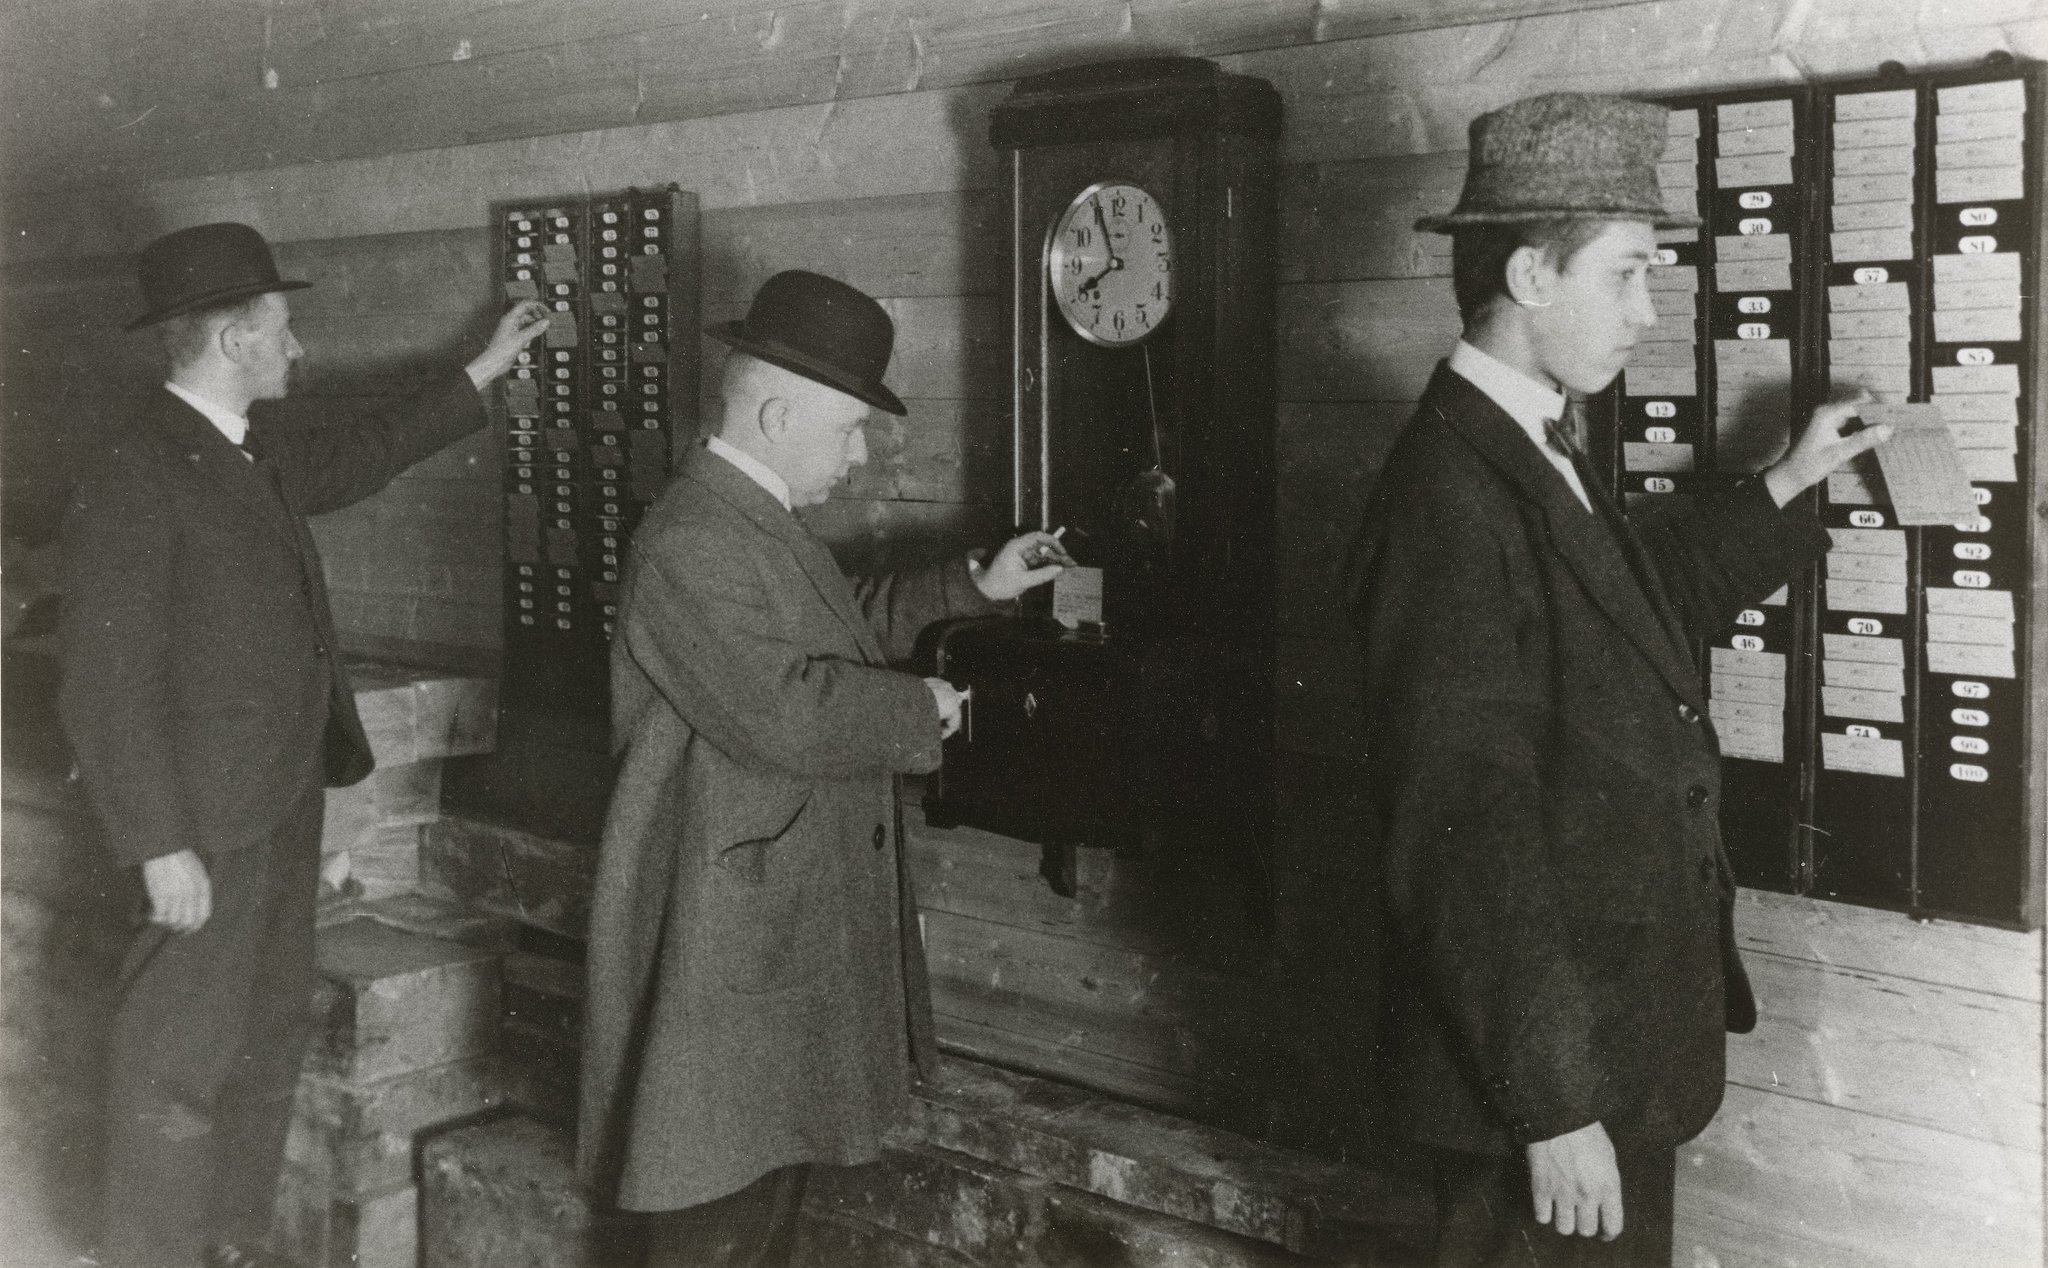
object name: photograph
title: Prikklok in een fabriek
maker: Anonymous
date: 1920-1935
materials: photographic support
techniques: photography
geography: netherlands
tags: labourers going to work, personnel in modern industry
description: Twee mannen met bolhoed en een jongeman met pet/hoed zijn bezig zich via een prikklok aan te melden op hun werk. Het is vijf voor acht.